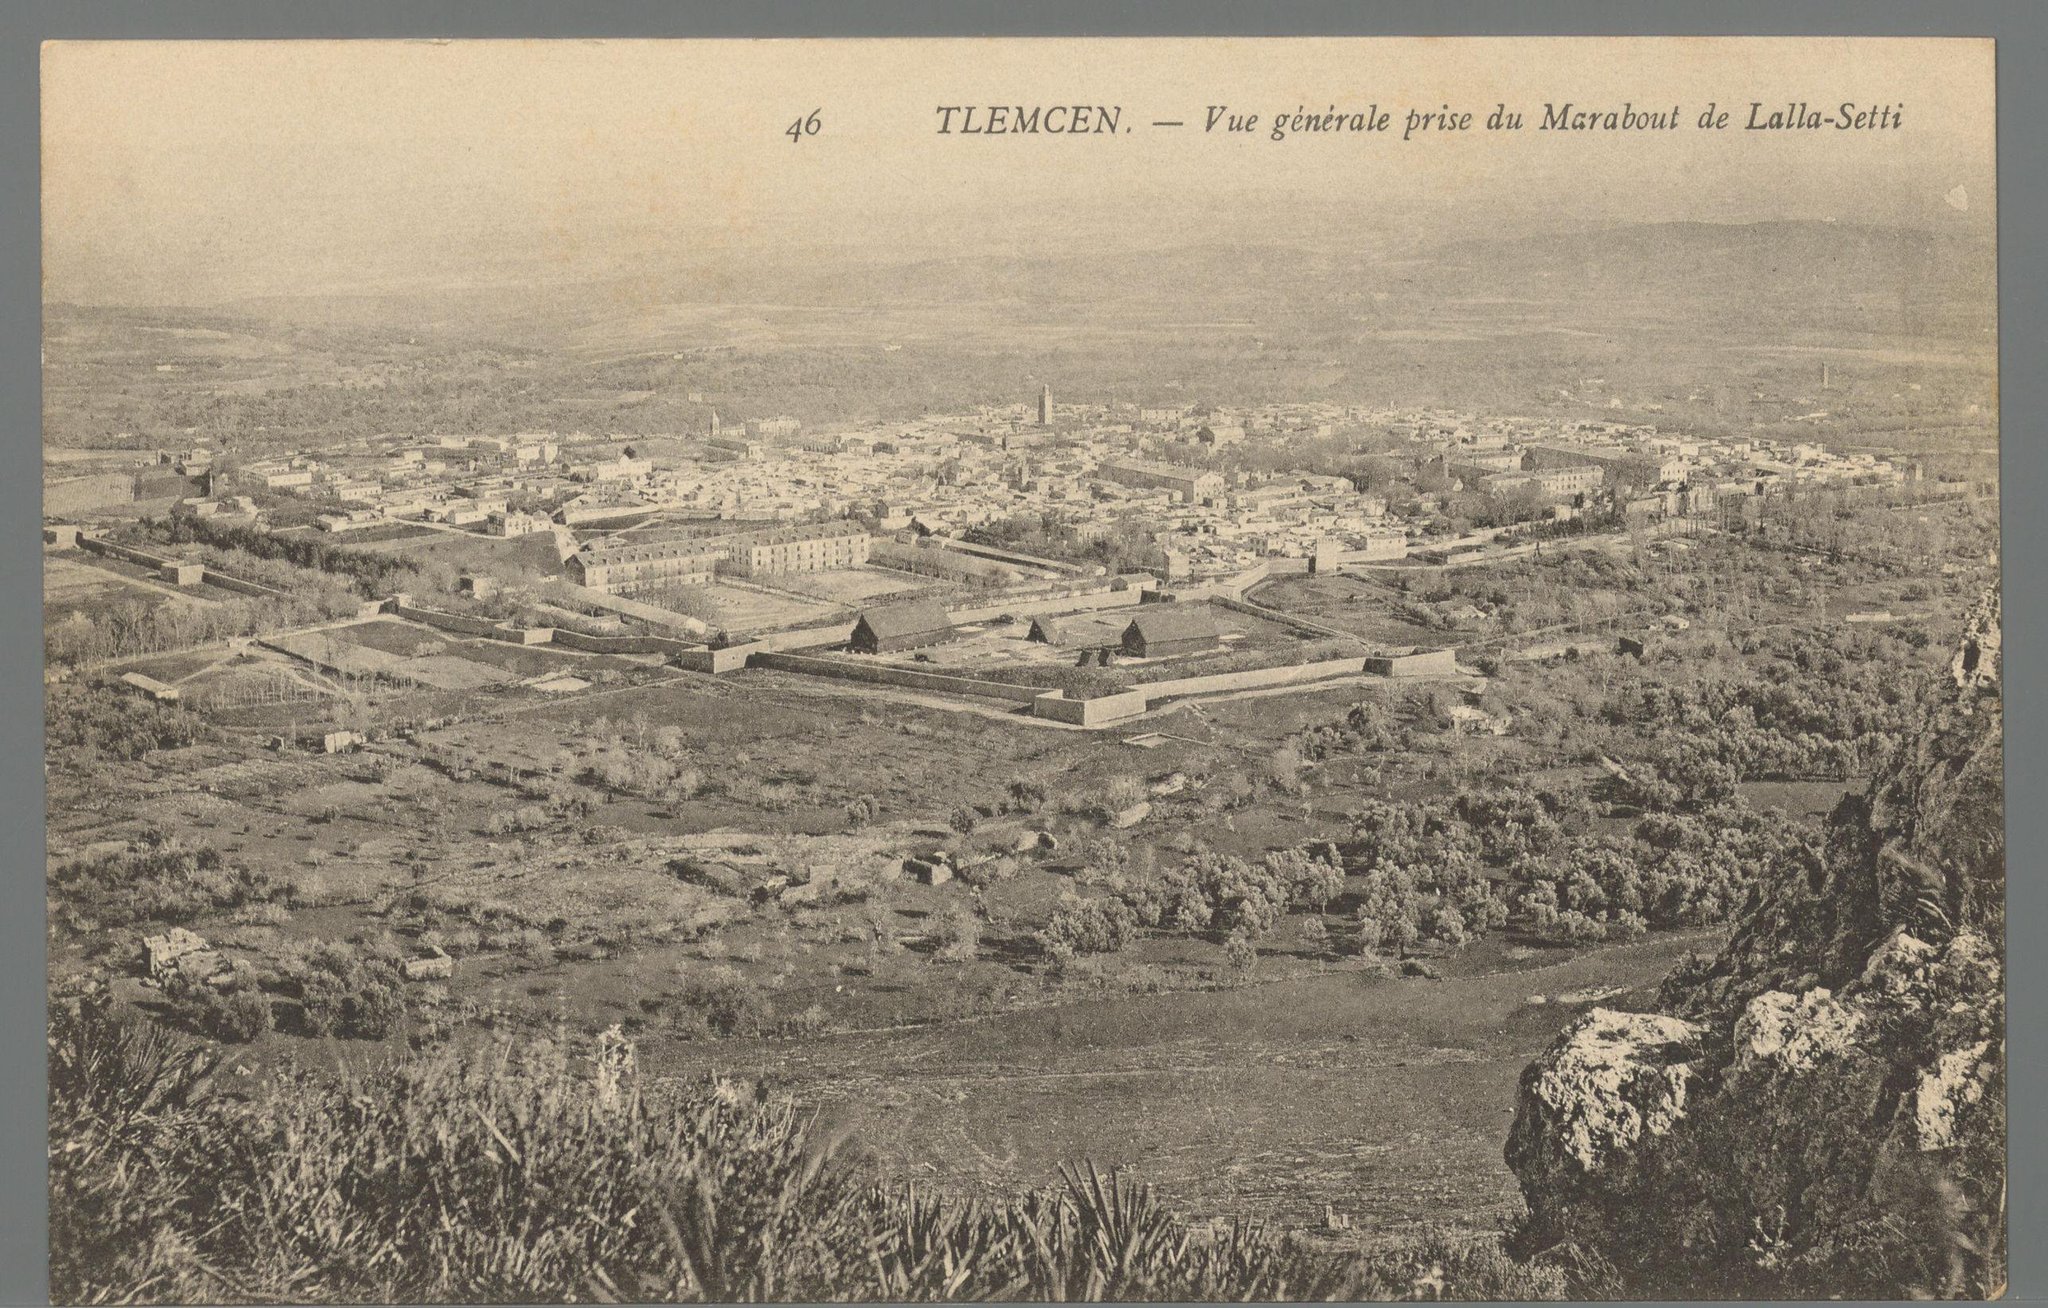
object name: ansichtkaart, prentbriefkaart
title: Tlemcen. Vue générale prise du Marbout de Lalla-Setti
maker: Anonymous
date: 1903-1905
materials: cardboard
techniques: photograph, writing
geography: tlemcen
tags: landscapes in the non-temperate zone, exotic landscapes, prospect of city, town panorama, silhouette of city